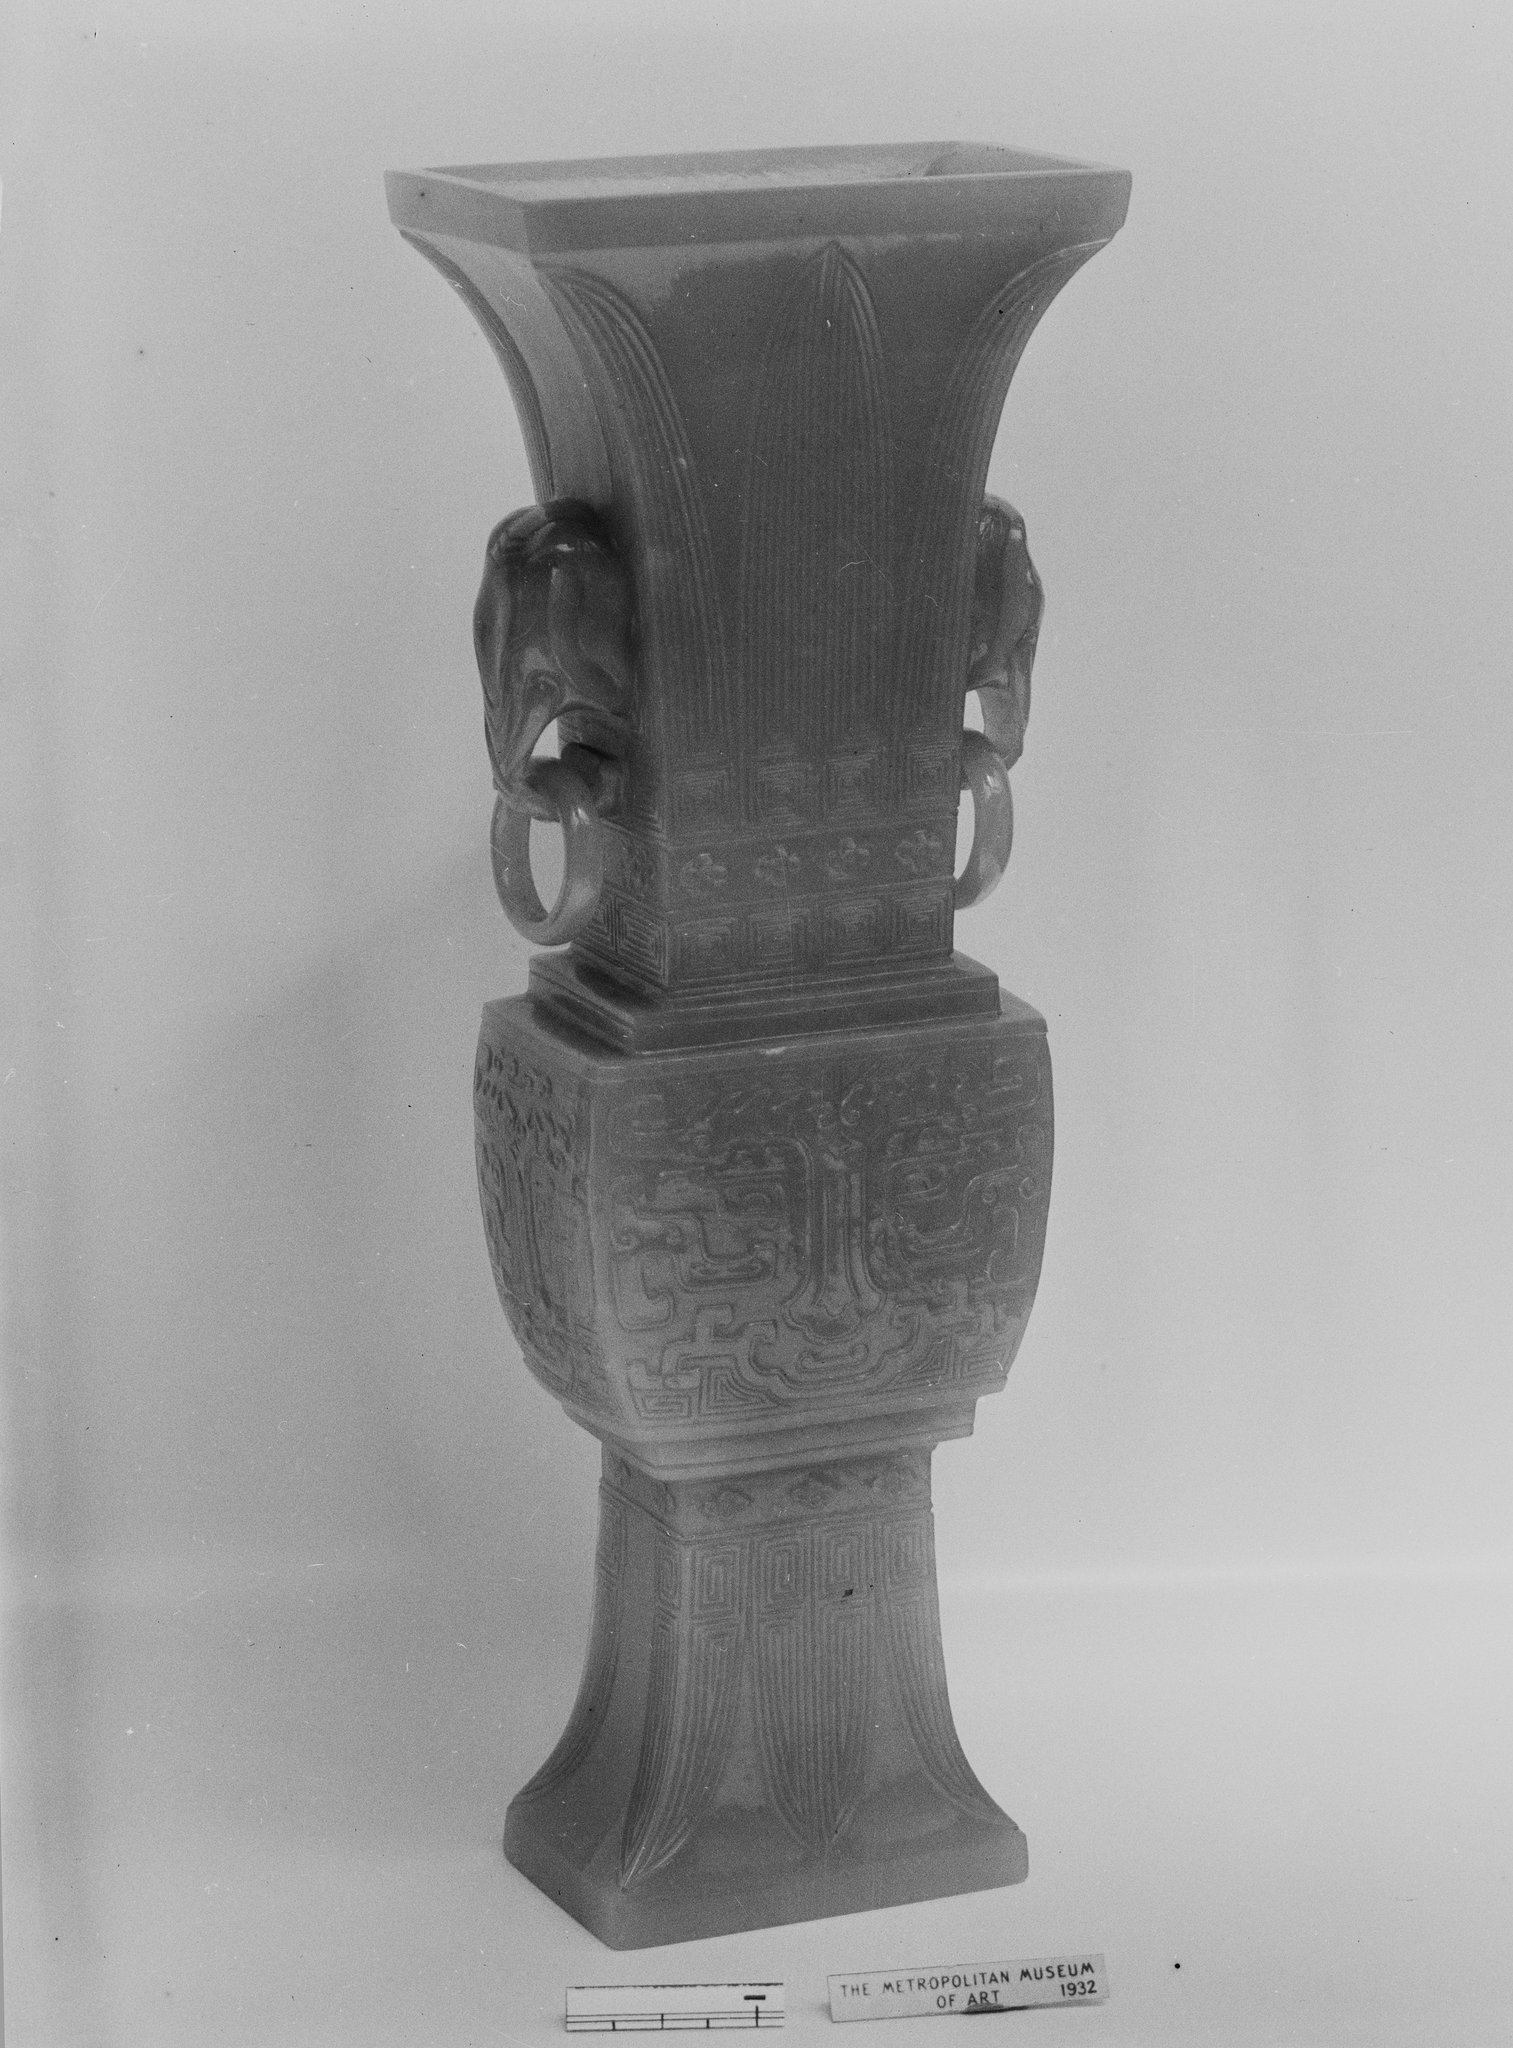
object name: vase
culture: chinese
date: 1736-1795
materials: jade